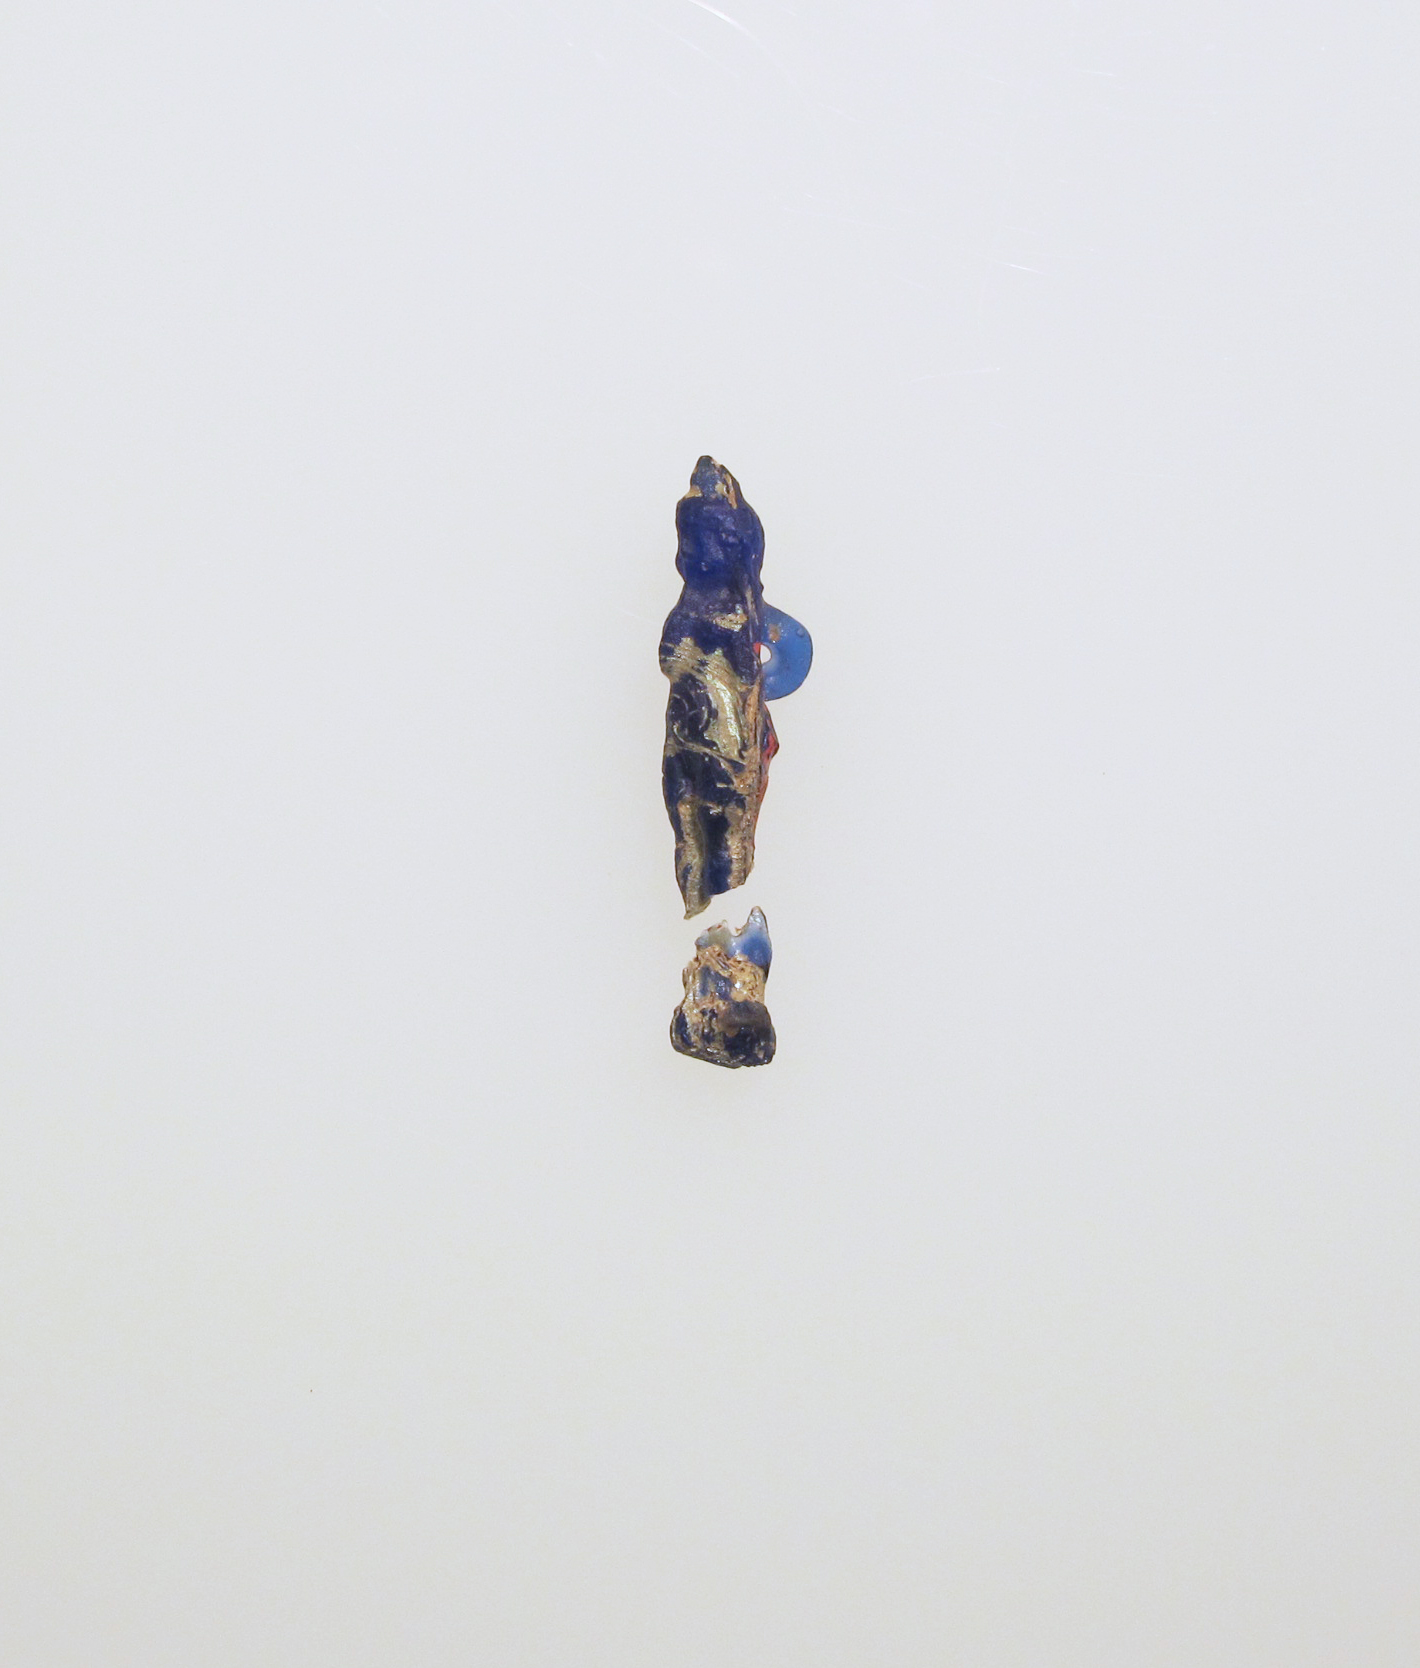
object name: pendant in the form of harpocrates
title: Glass pendant in the shape of Harpokrates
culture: greek, eastern mediterranean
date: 1-100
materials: glass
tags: harpokrates